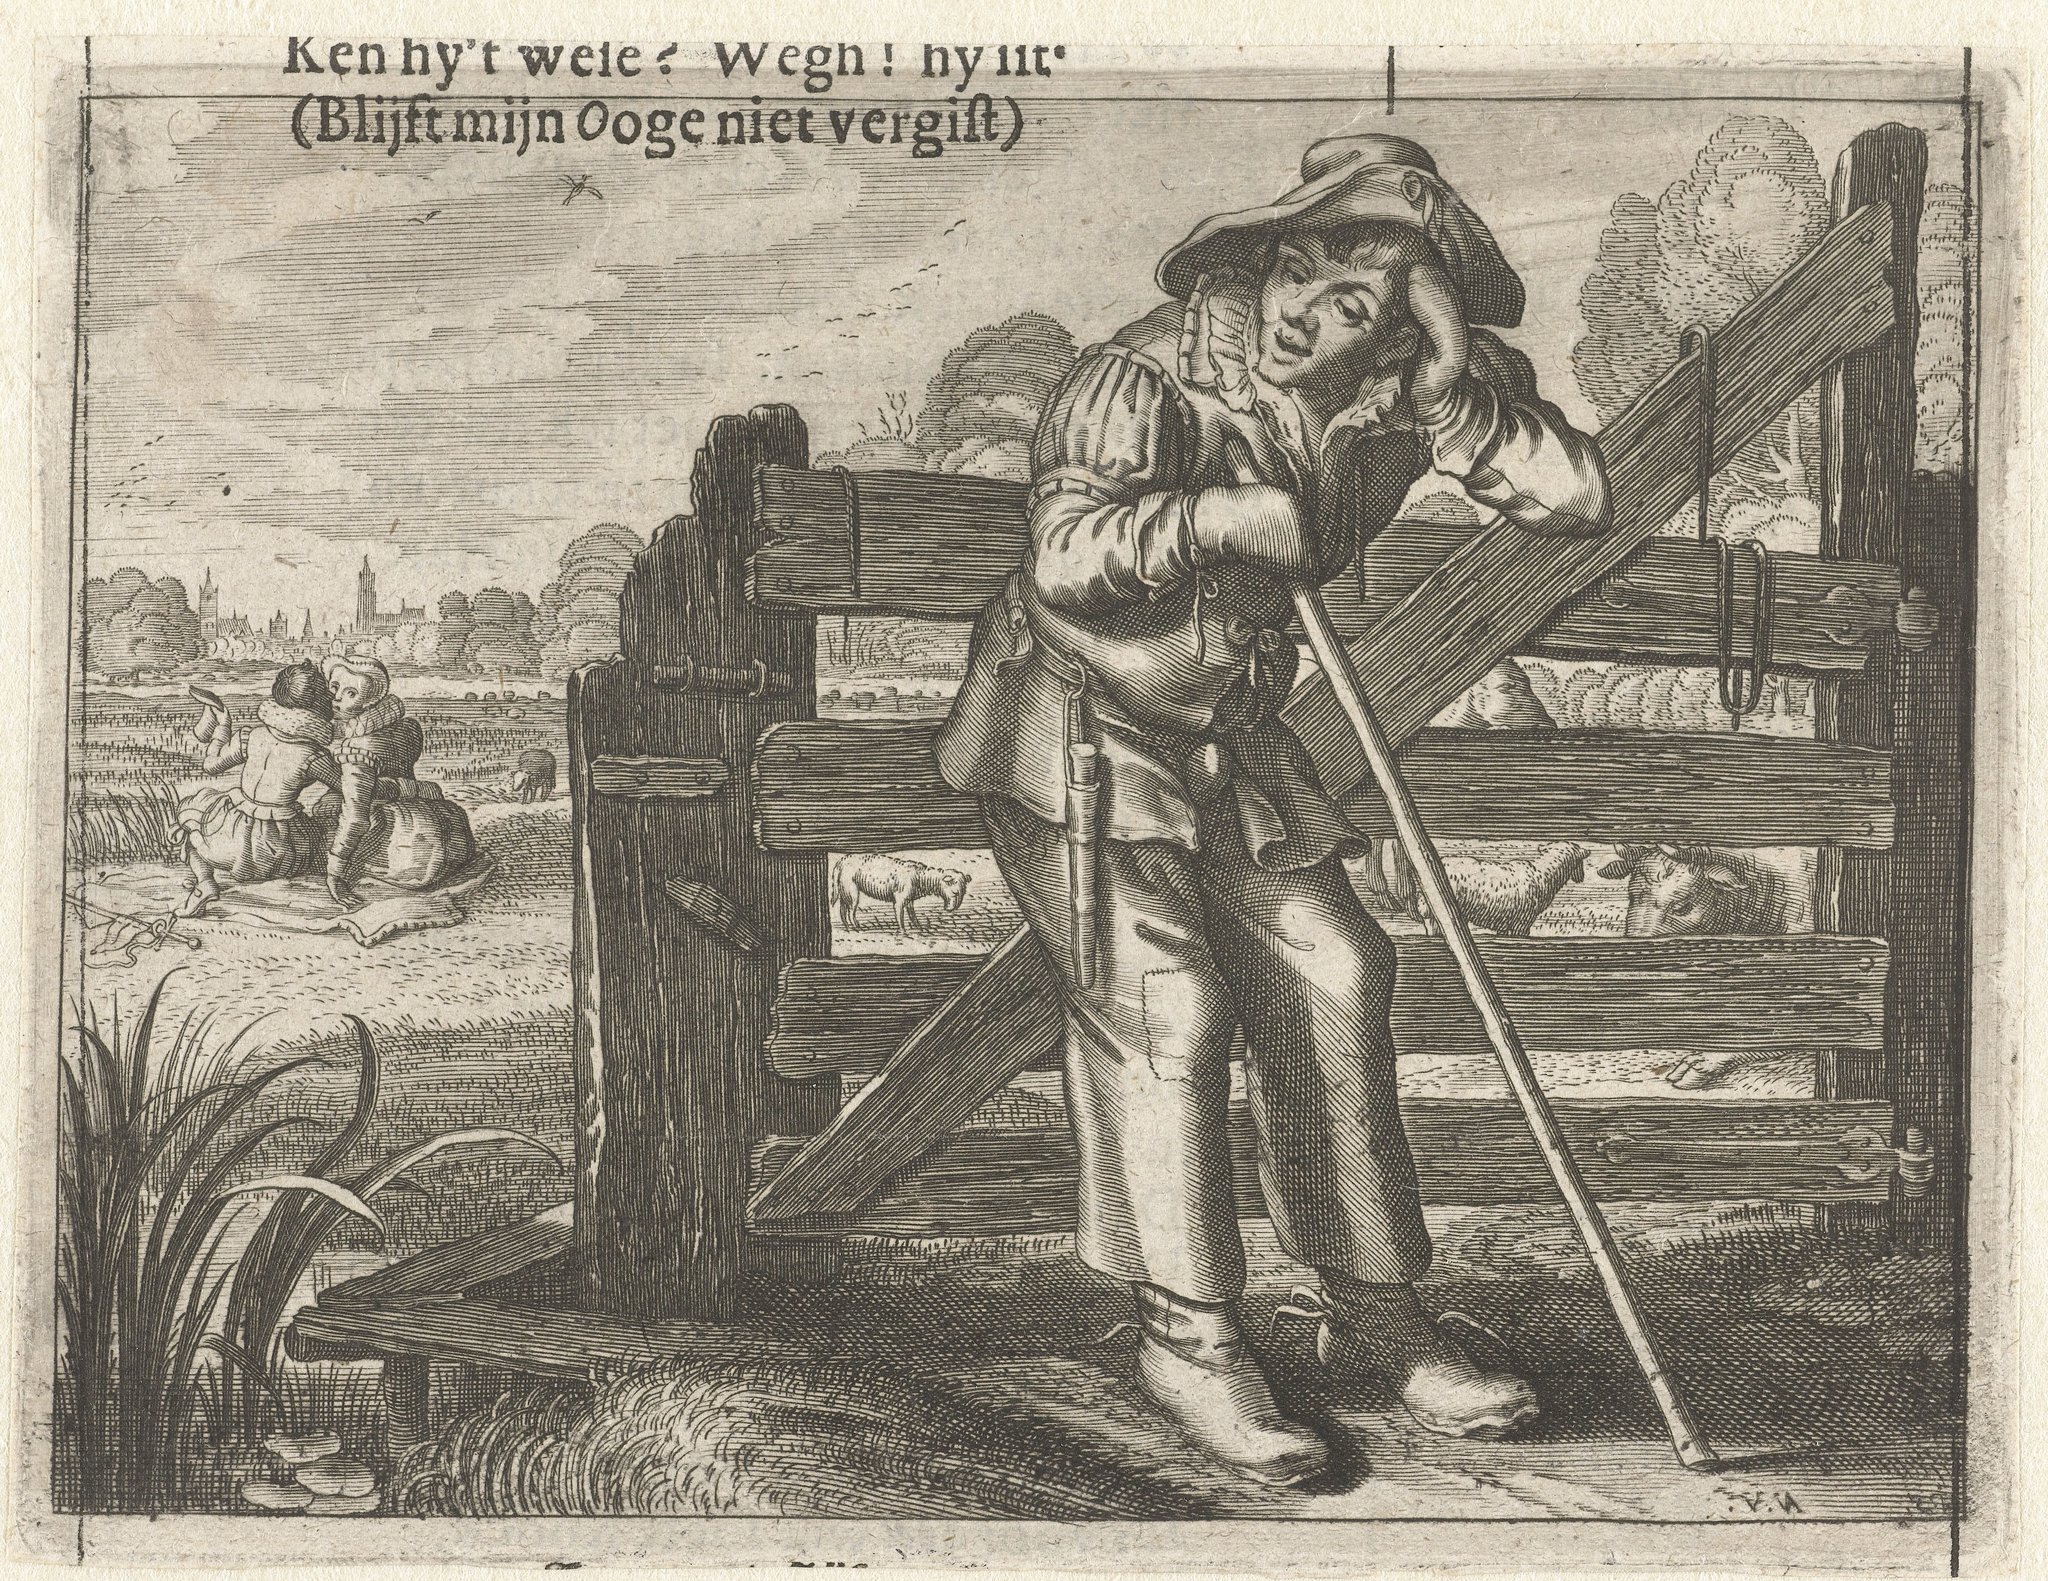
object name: print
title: Minne-Mall van Dicke Leendert, en Lijsje Teunis, met Ioncker Maerten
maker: pieter de jode (i)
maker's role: draughtsman, print maker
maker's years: 1570-1634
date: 1623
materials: paper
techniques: engraving, etching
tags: one of the lovers alone (e.g. longing for the beloved), eavesdropper, lovers spied upon, couple of lovers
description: Illustratie in Adriaen van de Venne's 'Tafereel van de Belacchende Werelt' van 1635 (?): Minne-Mall van Dicke Leendert, en Lijsje Teunis, met Ioncker Maerten.